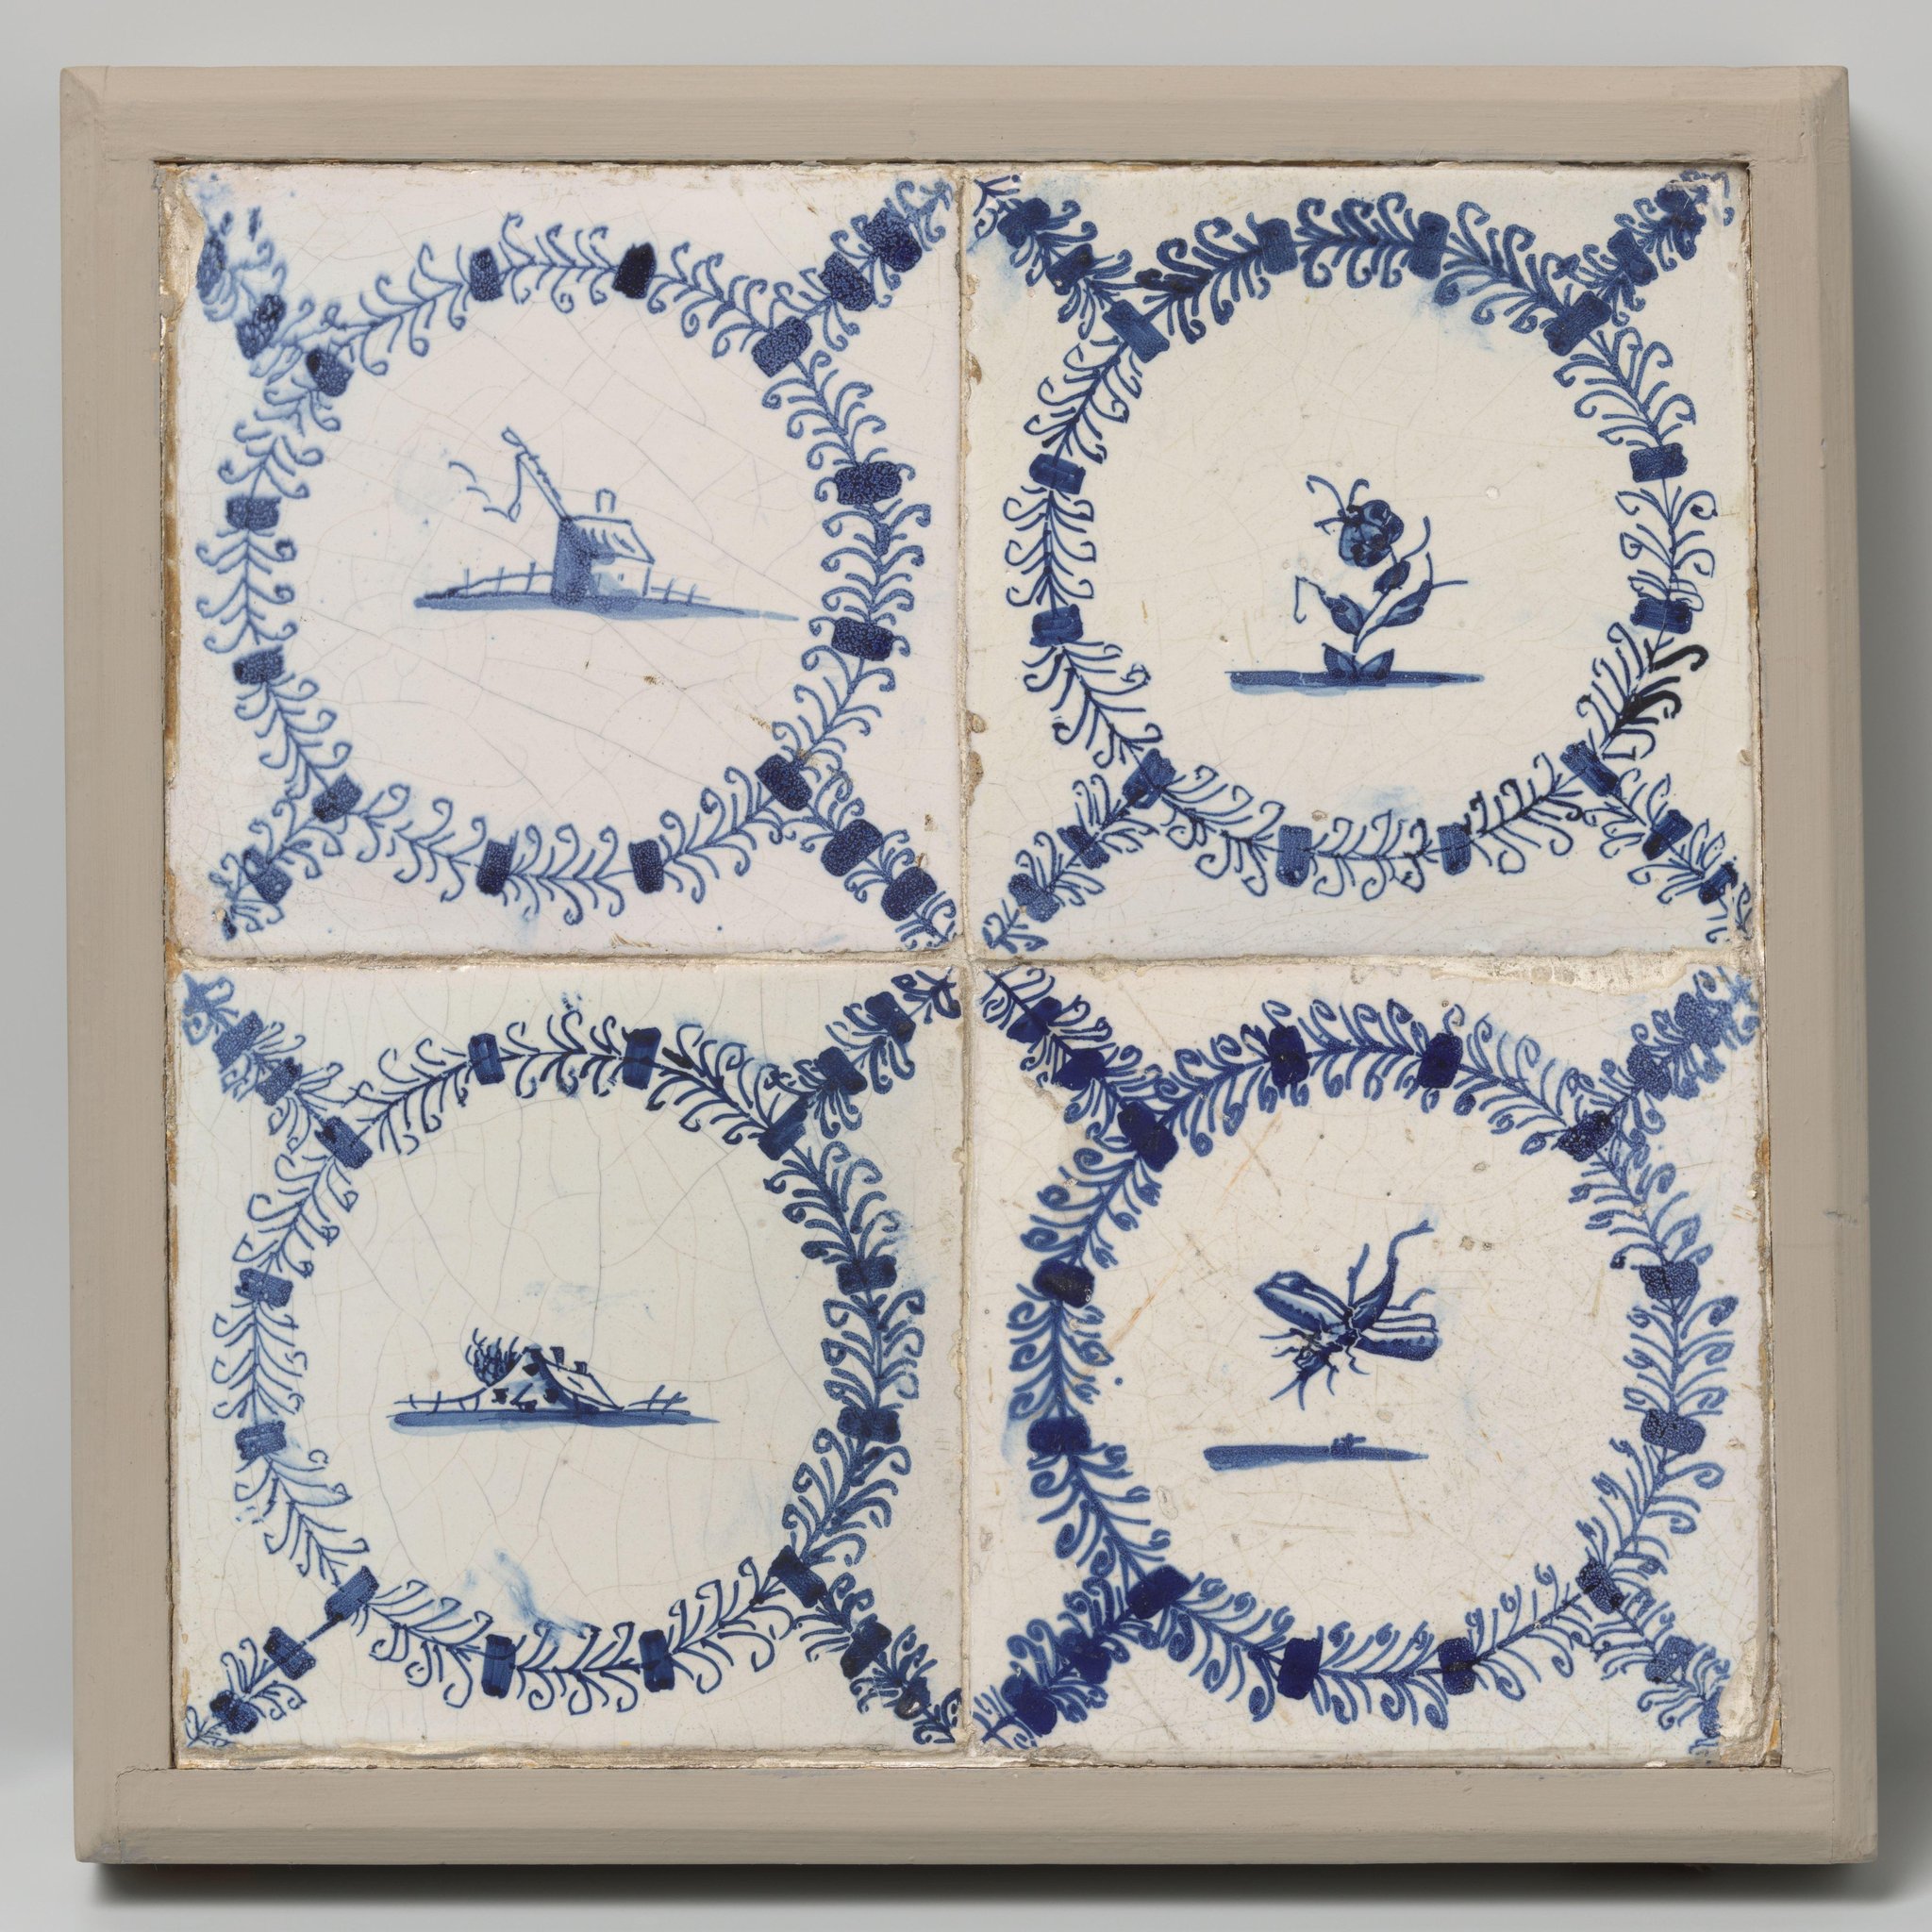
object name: tile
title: Veld van vier tegels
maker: Anonymous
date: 1650-1670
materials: earthenware, glaze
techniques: maiolica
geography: haarlem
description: Veld van 4 tegels (2 x 2) elk met een blauw geschilderd landschapje, bloem of insect binnen een krans met veertoef. In de hoeken, een veertoef.